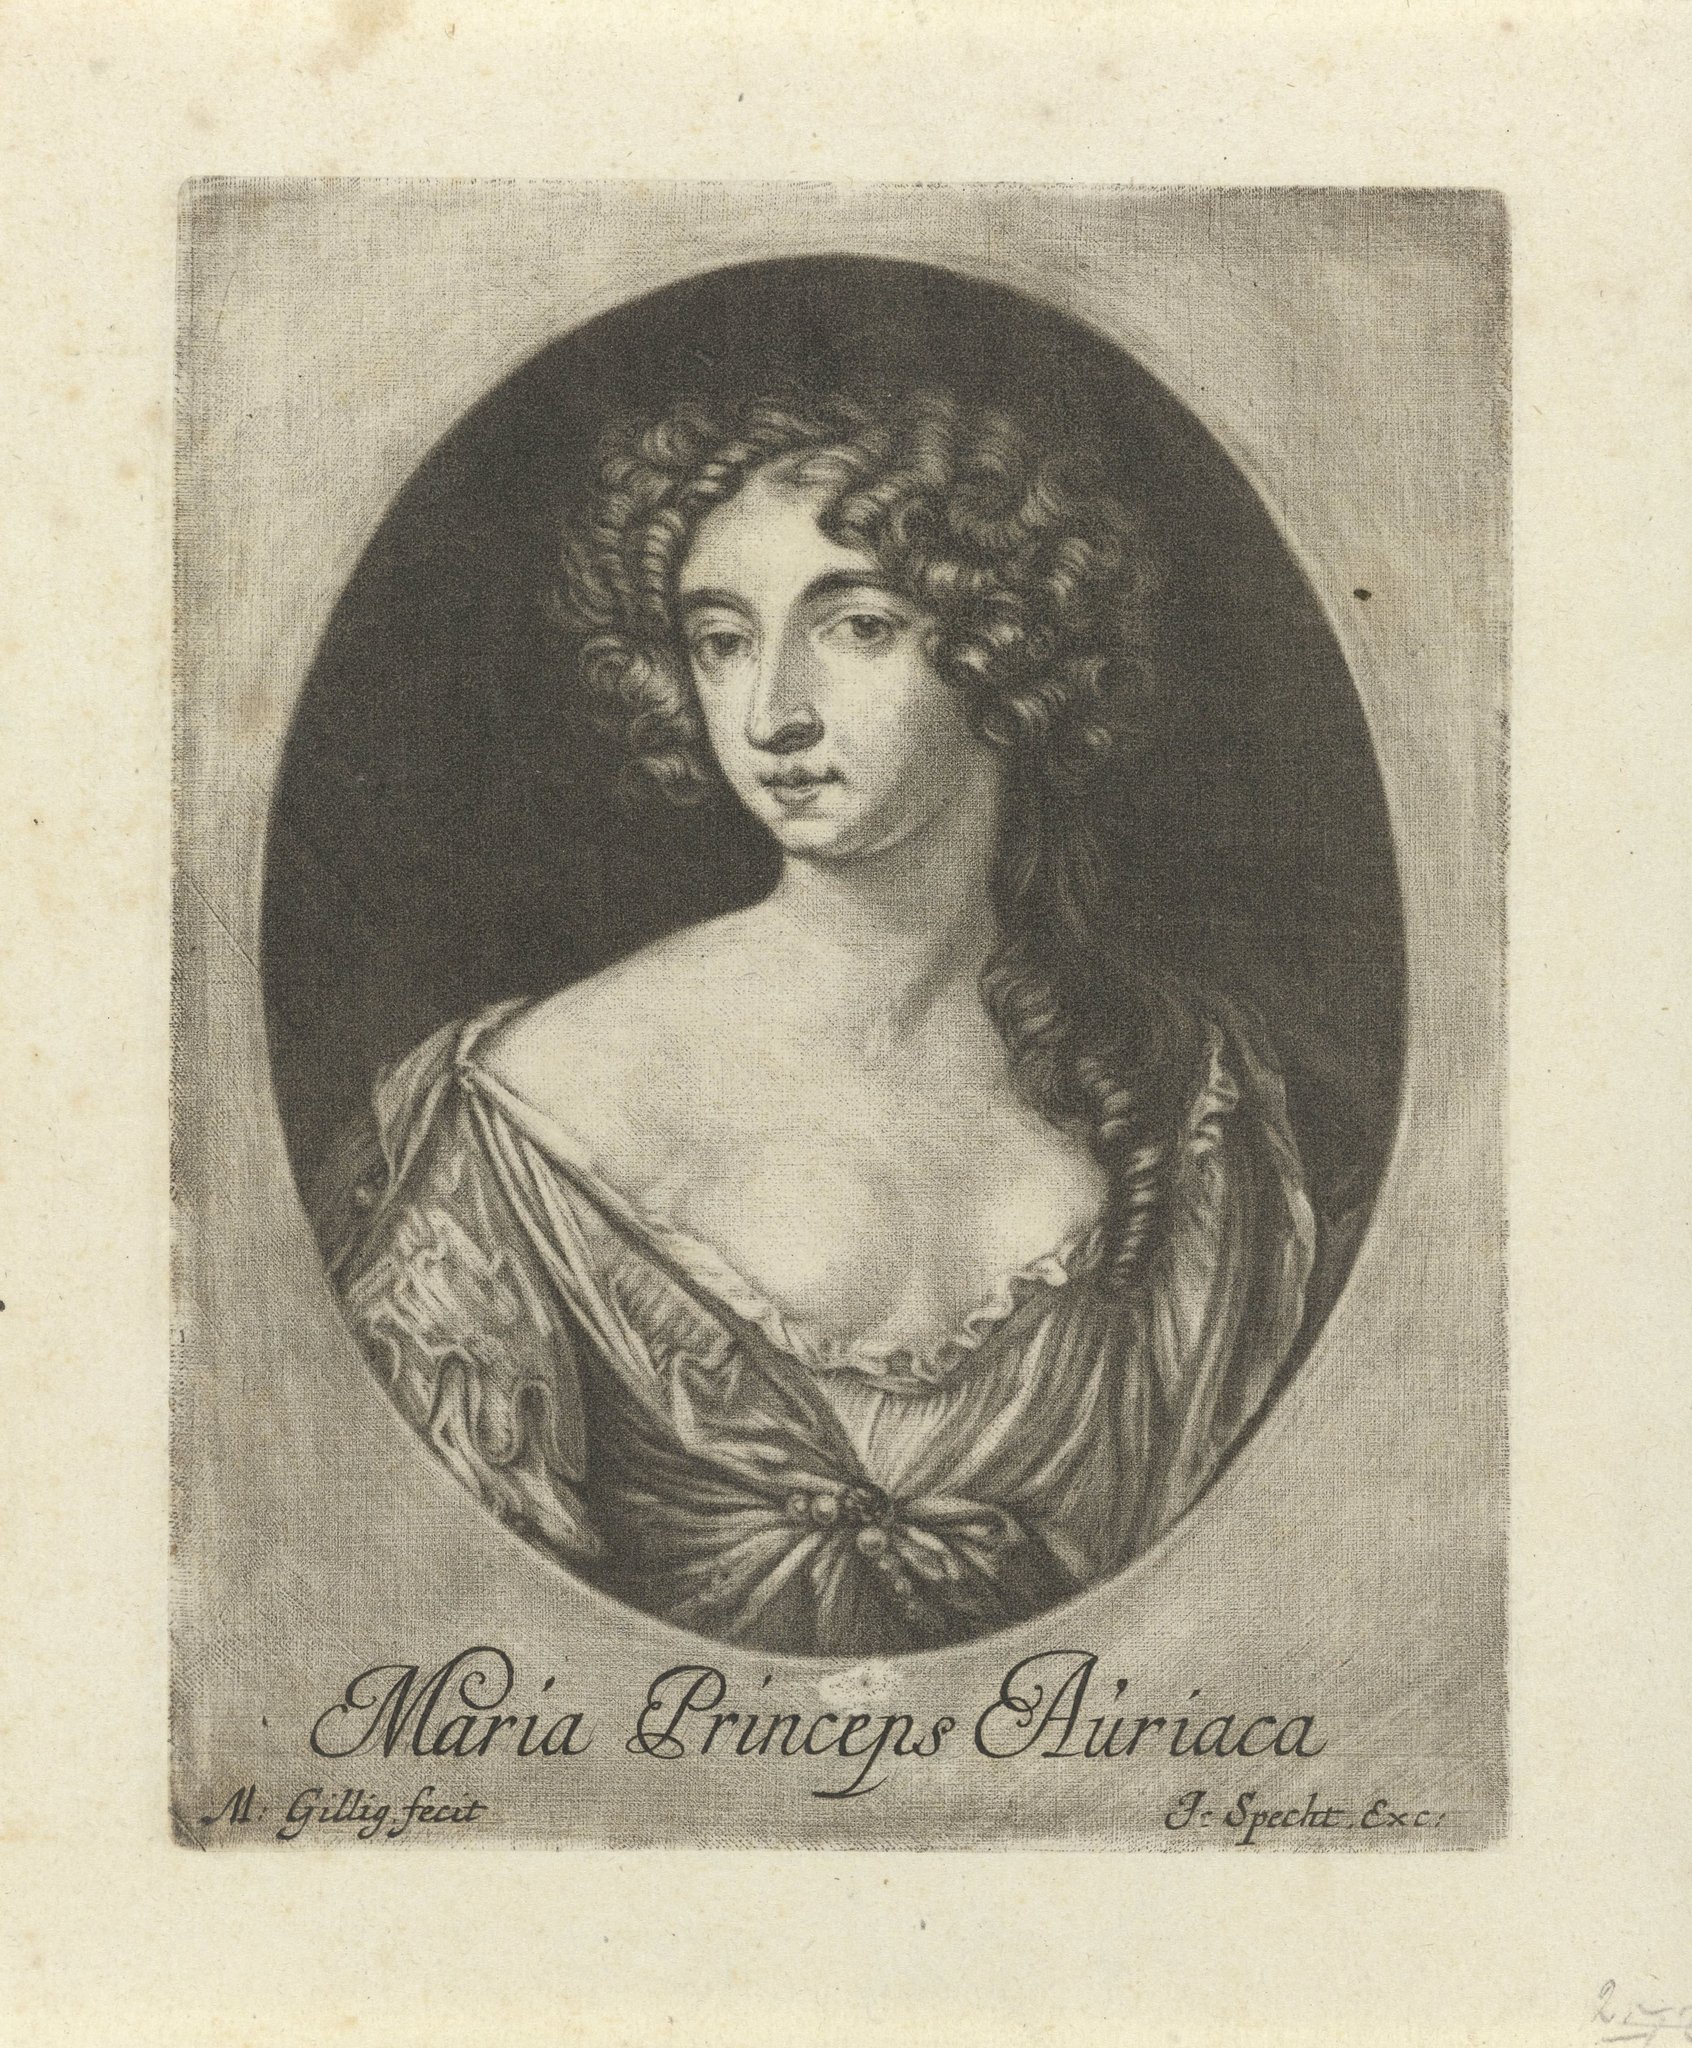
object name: print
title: Portret van Maria II Stuart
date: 1677-1708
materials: paper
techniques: mezzotint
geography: utrecht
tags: london, maria ii stuart (koningin van engeland, schotland en ierland)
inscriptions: collector's mark: Lugt 2228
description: Portret van Maria II in een ovaal. In de ondermarge haar naam en titel.